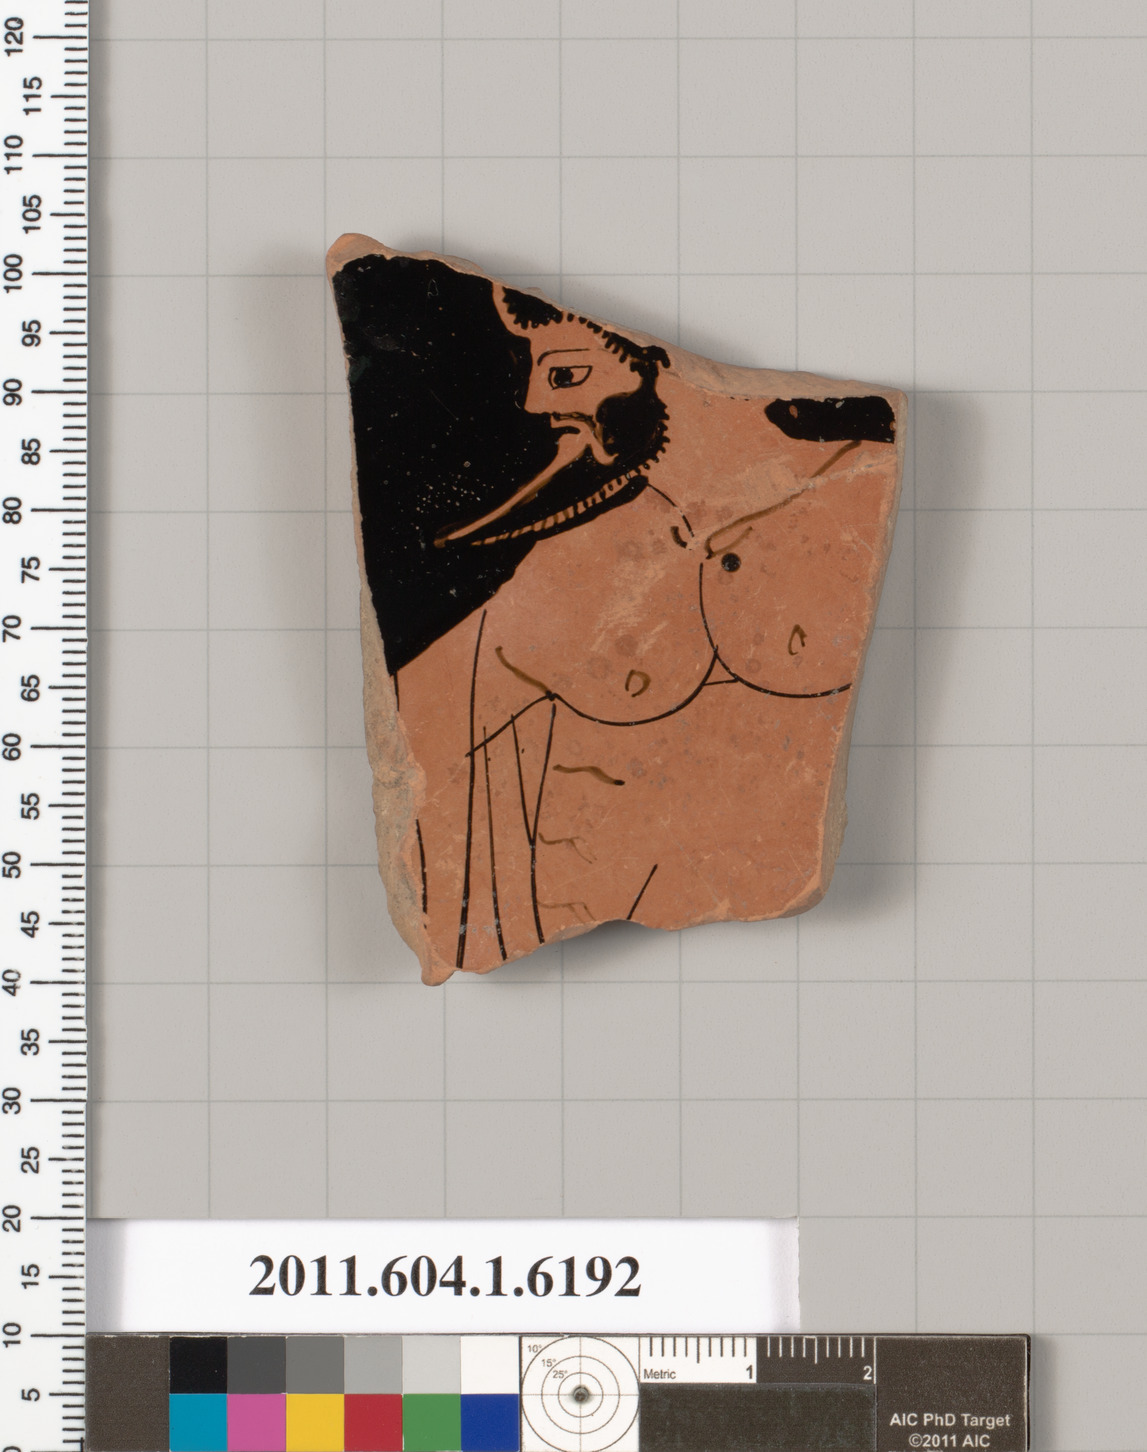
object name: kylix fragment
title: Terracotta fragment of a kylix (drinking cup)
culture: greek, attic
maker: painter of berlin 2268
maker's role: artist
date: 510-500 BCE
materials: terracotta